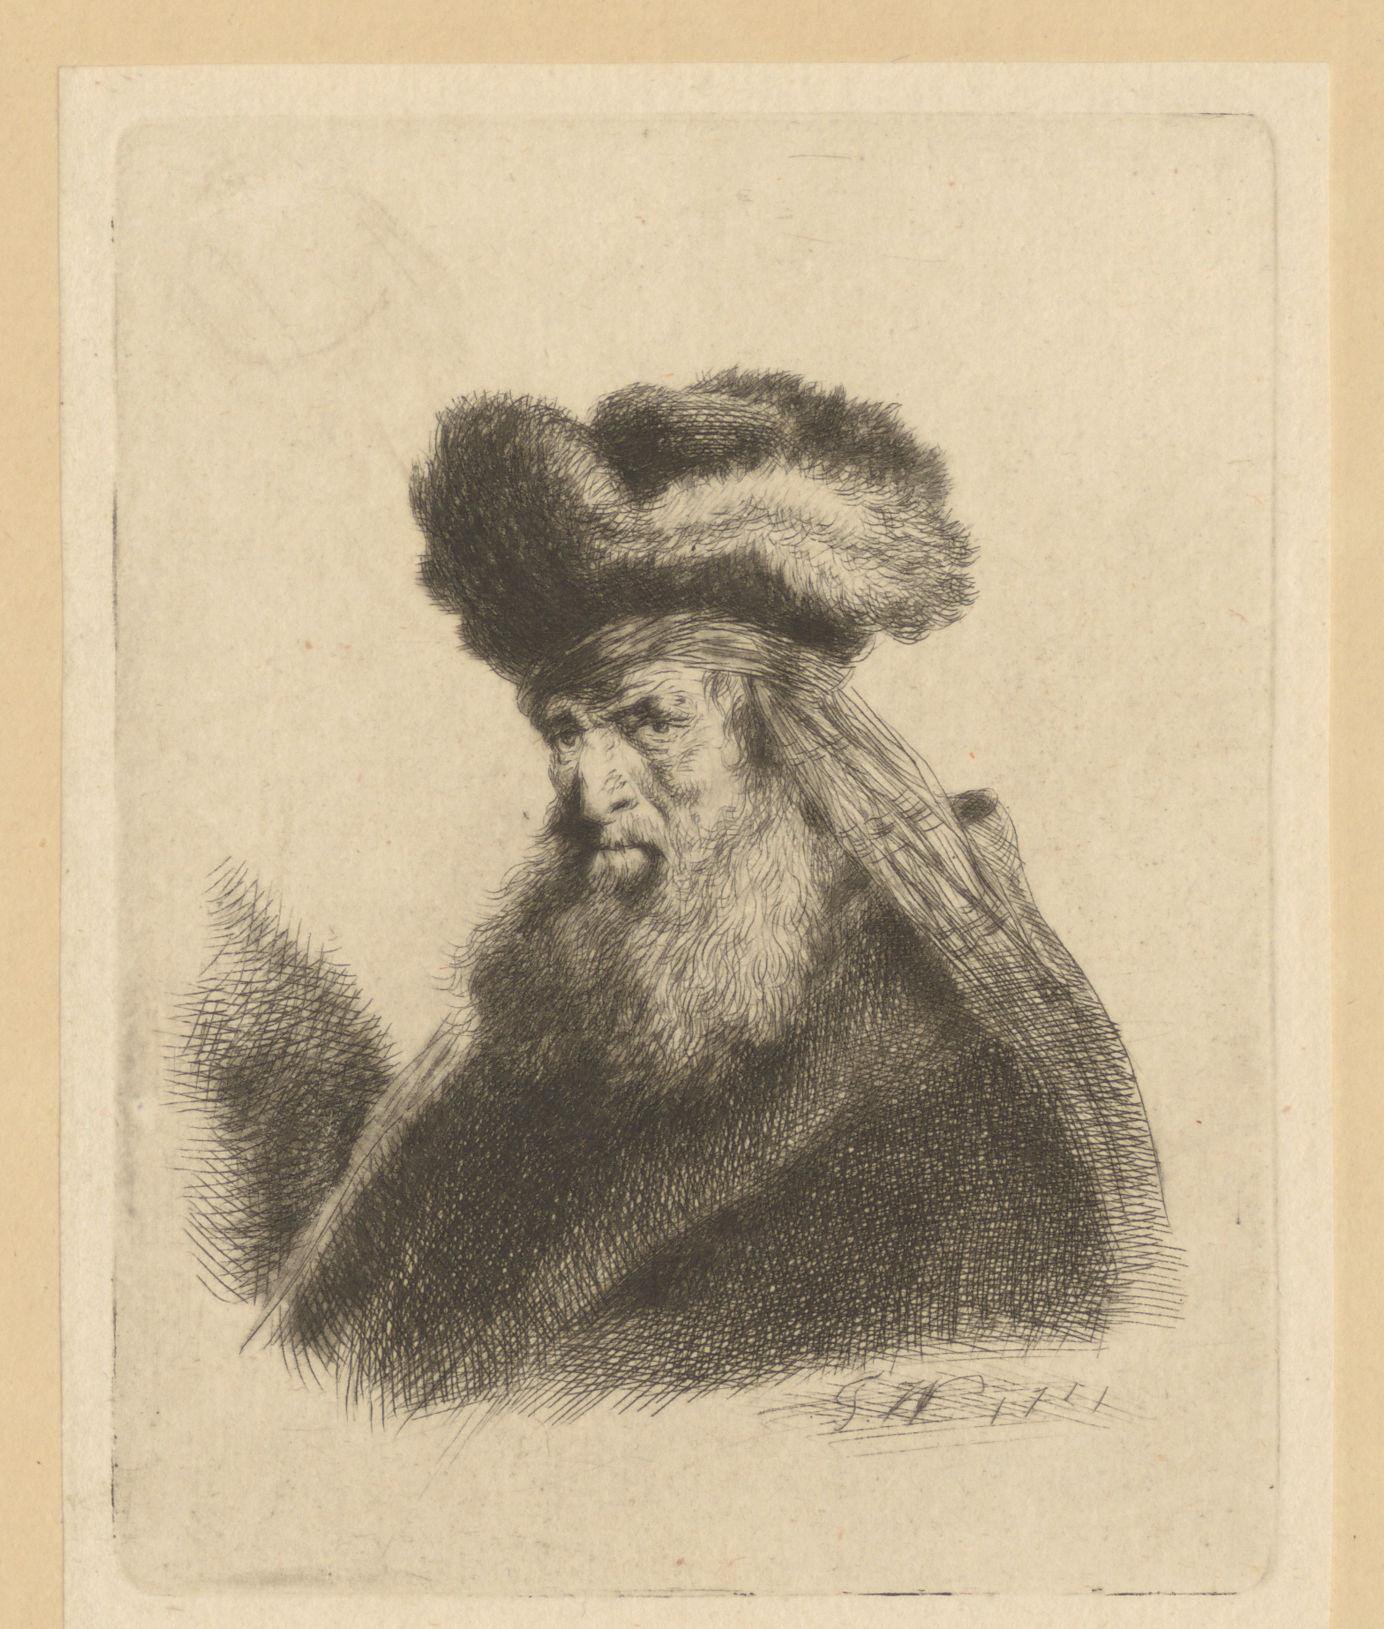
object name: print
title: Portret van onbekende man met baard en bontmuts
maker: thomas worlidge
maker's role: print maker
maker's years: 1700-1766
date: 1751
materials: paper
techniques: drypoint, etching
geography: london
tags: head-gear (with name), anonymous historical person portrayed alone, false beard or moustache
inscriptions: date